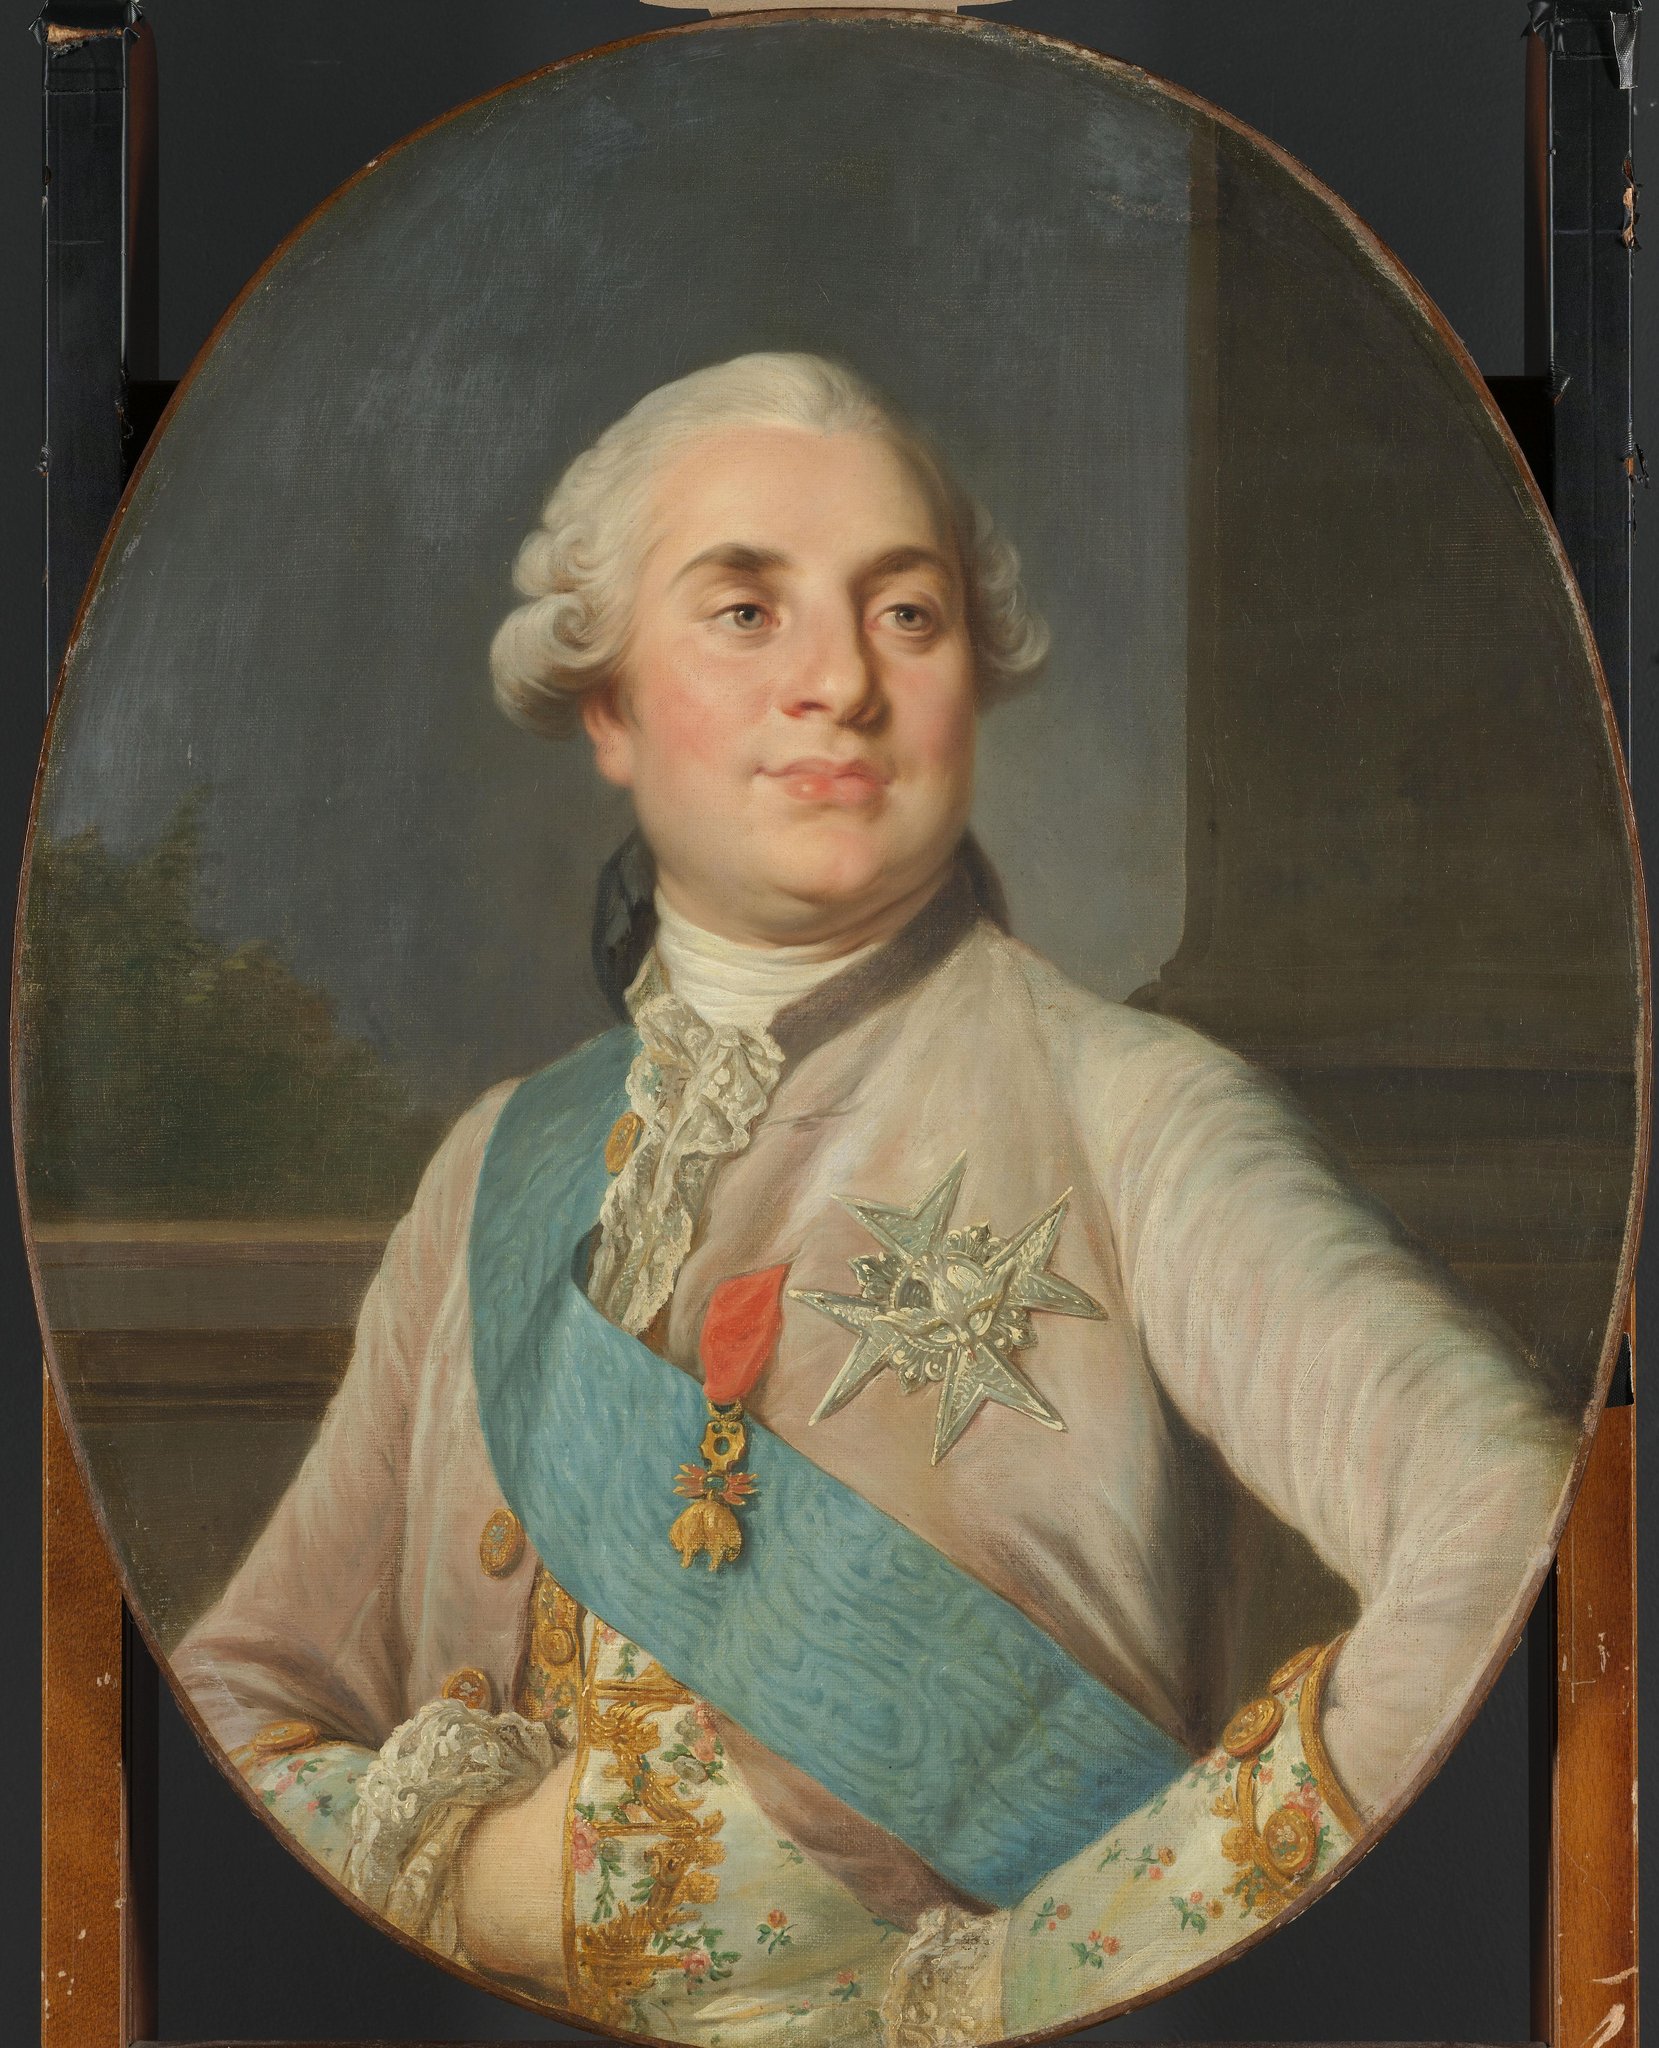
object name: painting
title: Louis XVI (1754-1793), King of France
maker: joseph duplessis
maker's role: artist, painter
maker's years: 1725-1802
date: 1777-1789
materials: canvas, oil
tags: paris, lodewijk xvi (koning van frankrijk), historical persons, france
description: Duplessis painted the first version of this portrait in 1777. Although the king wears his principal chivalric orders, he is portrayed in relatively simple attire and assumes an informal pose. This portrait found great favour, and Duplessis was repeatedly commissioned to copy it. This likeness was thus widely disseminated and hung in government buildings and palaces, among other places.